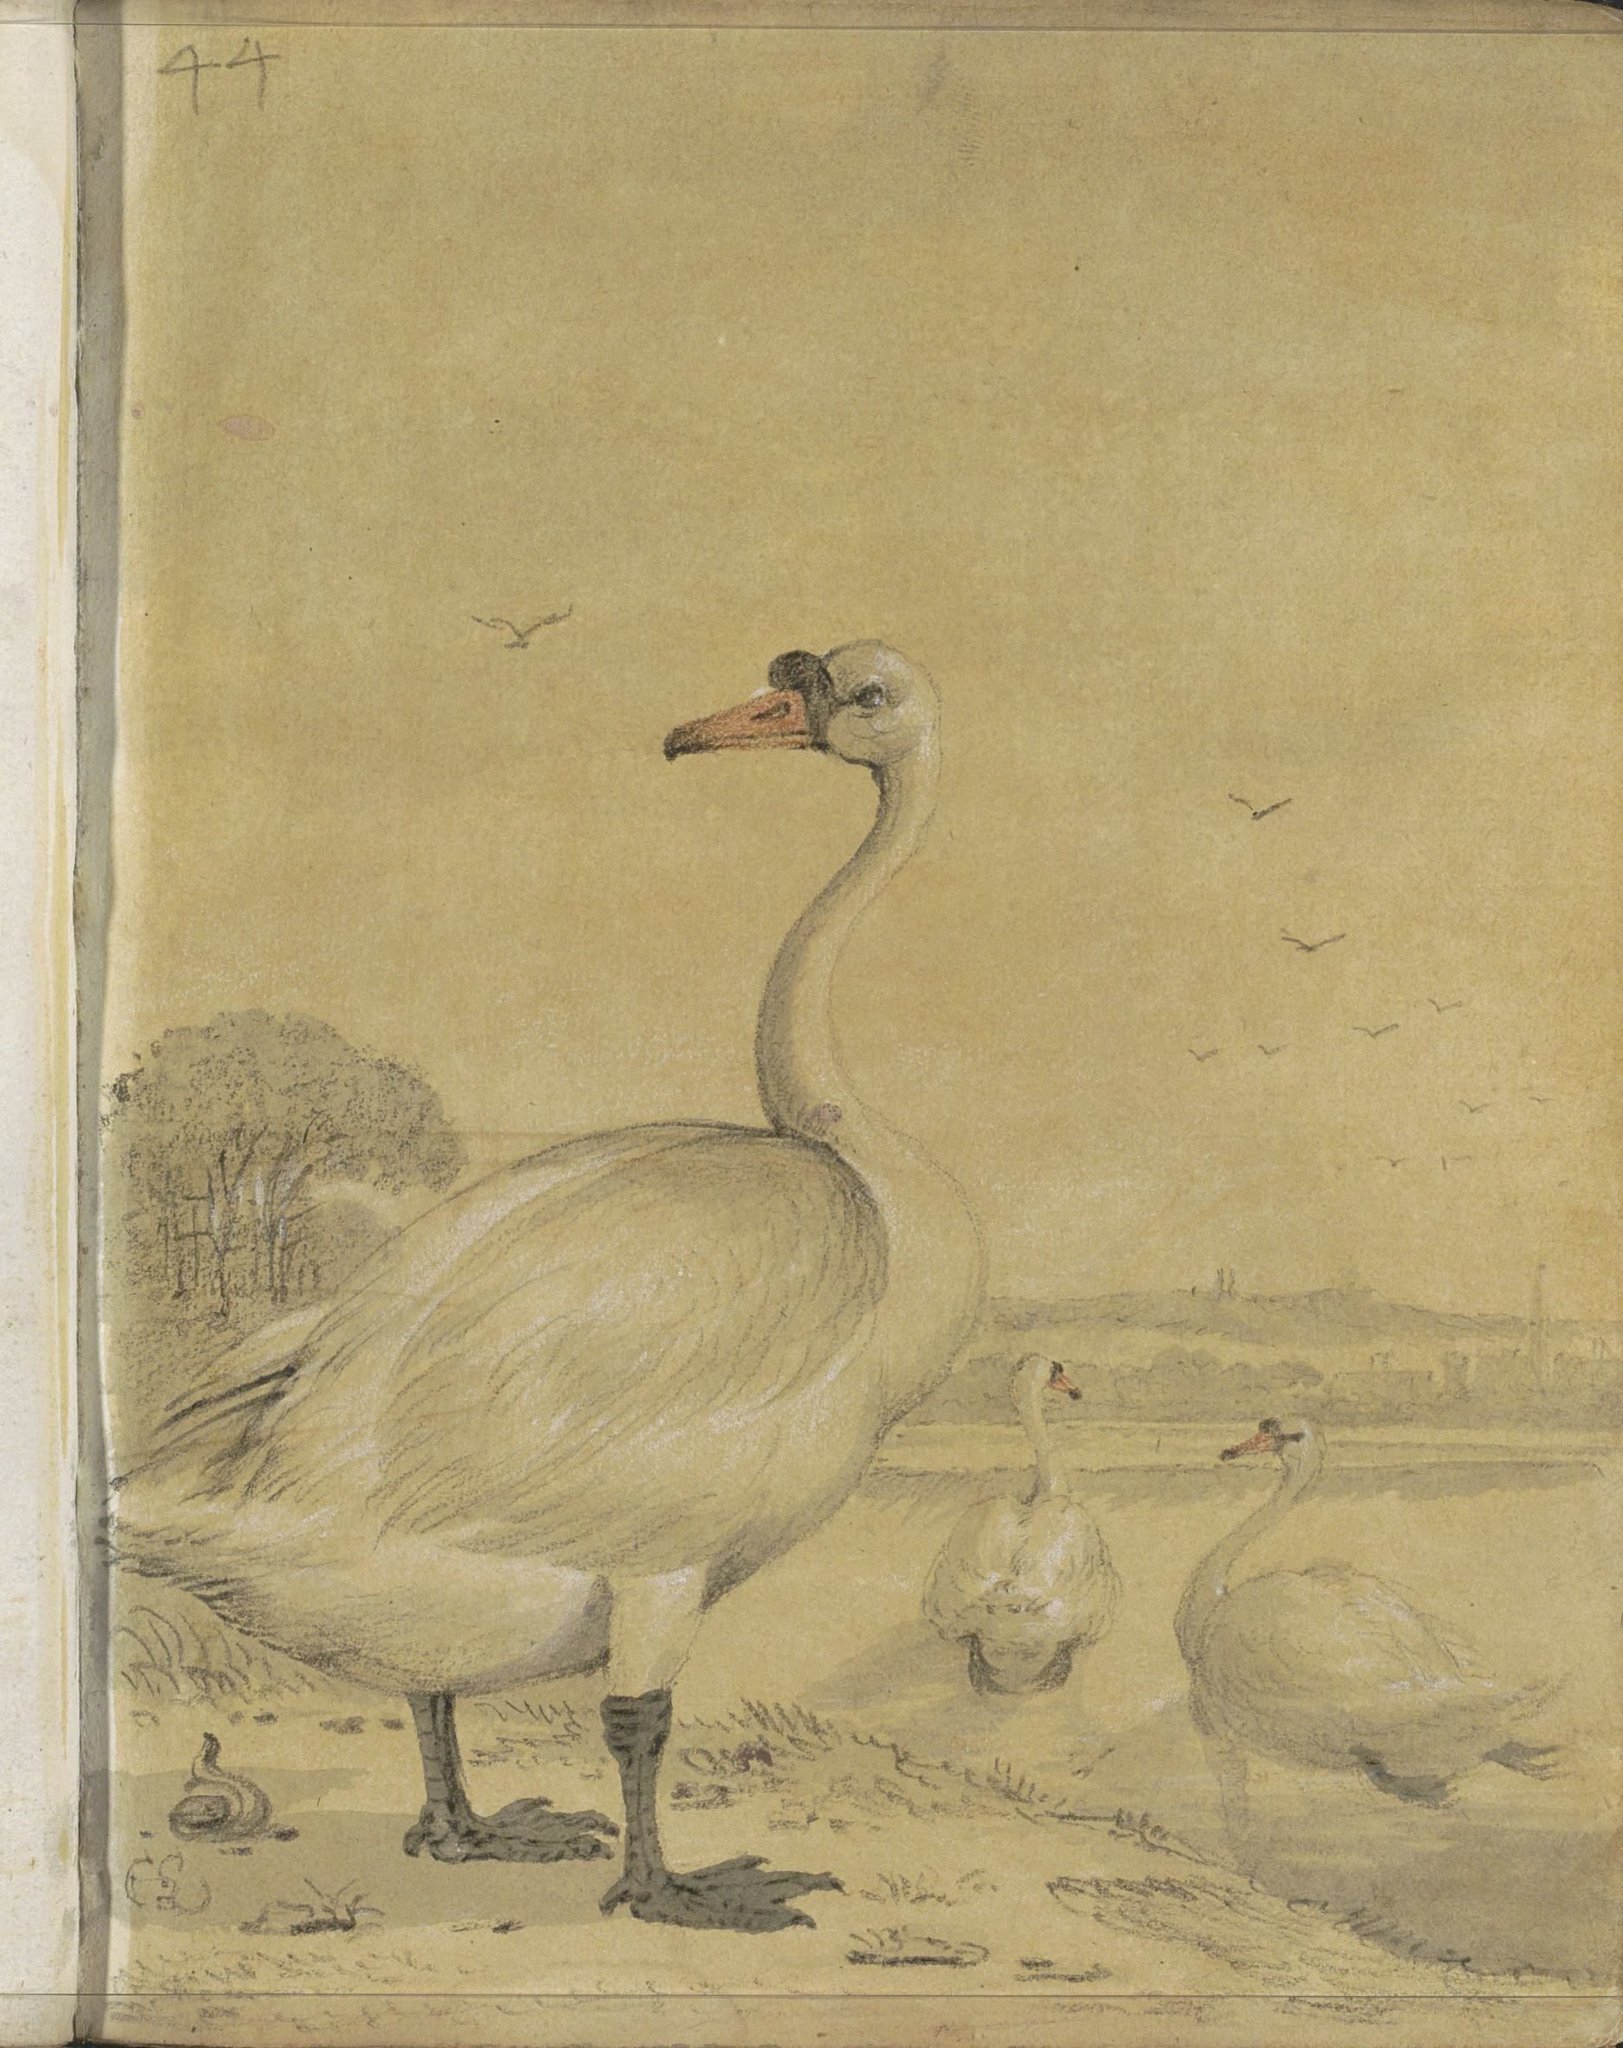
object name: sketchbook leaf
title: Landschap met een zwaan aan een waterkant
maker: cornelis saftleven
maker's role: draughtsman, painter, print maker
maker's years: 1607-1681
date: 1666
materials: chalk, ink, paper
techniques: brush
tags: water-birds: swan, landscapes with waters, waterscapes, seascapes (in the temperate zone)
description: Op het water zwemmen twee zwanen. Op de achtergrond bebouwing. Blad 44 recto uit een schetsboek met 49 bladen.